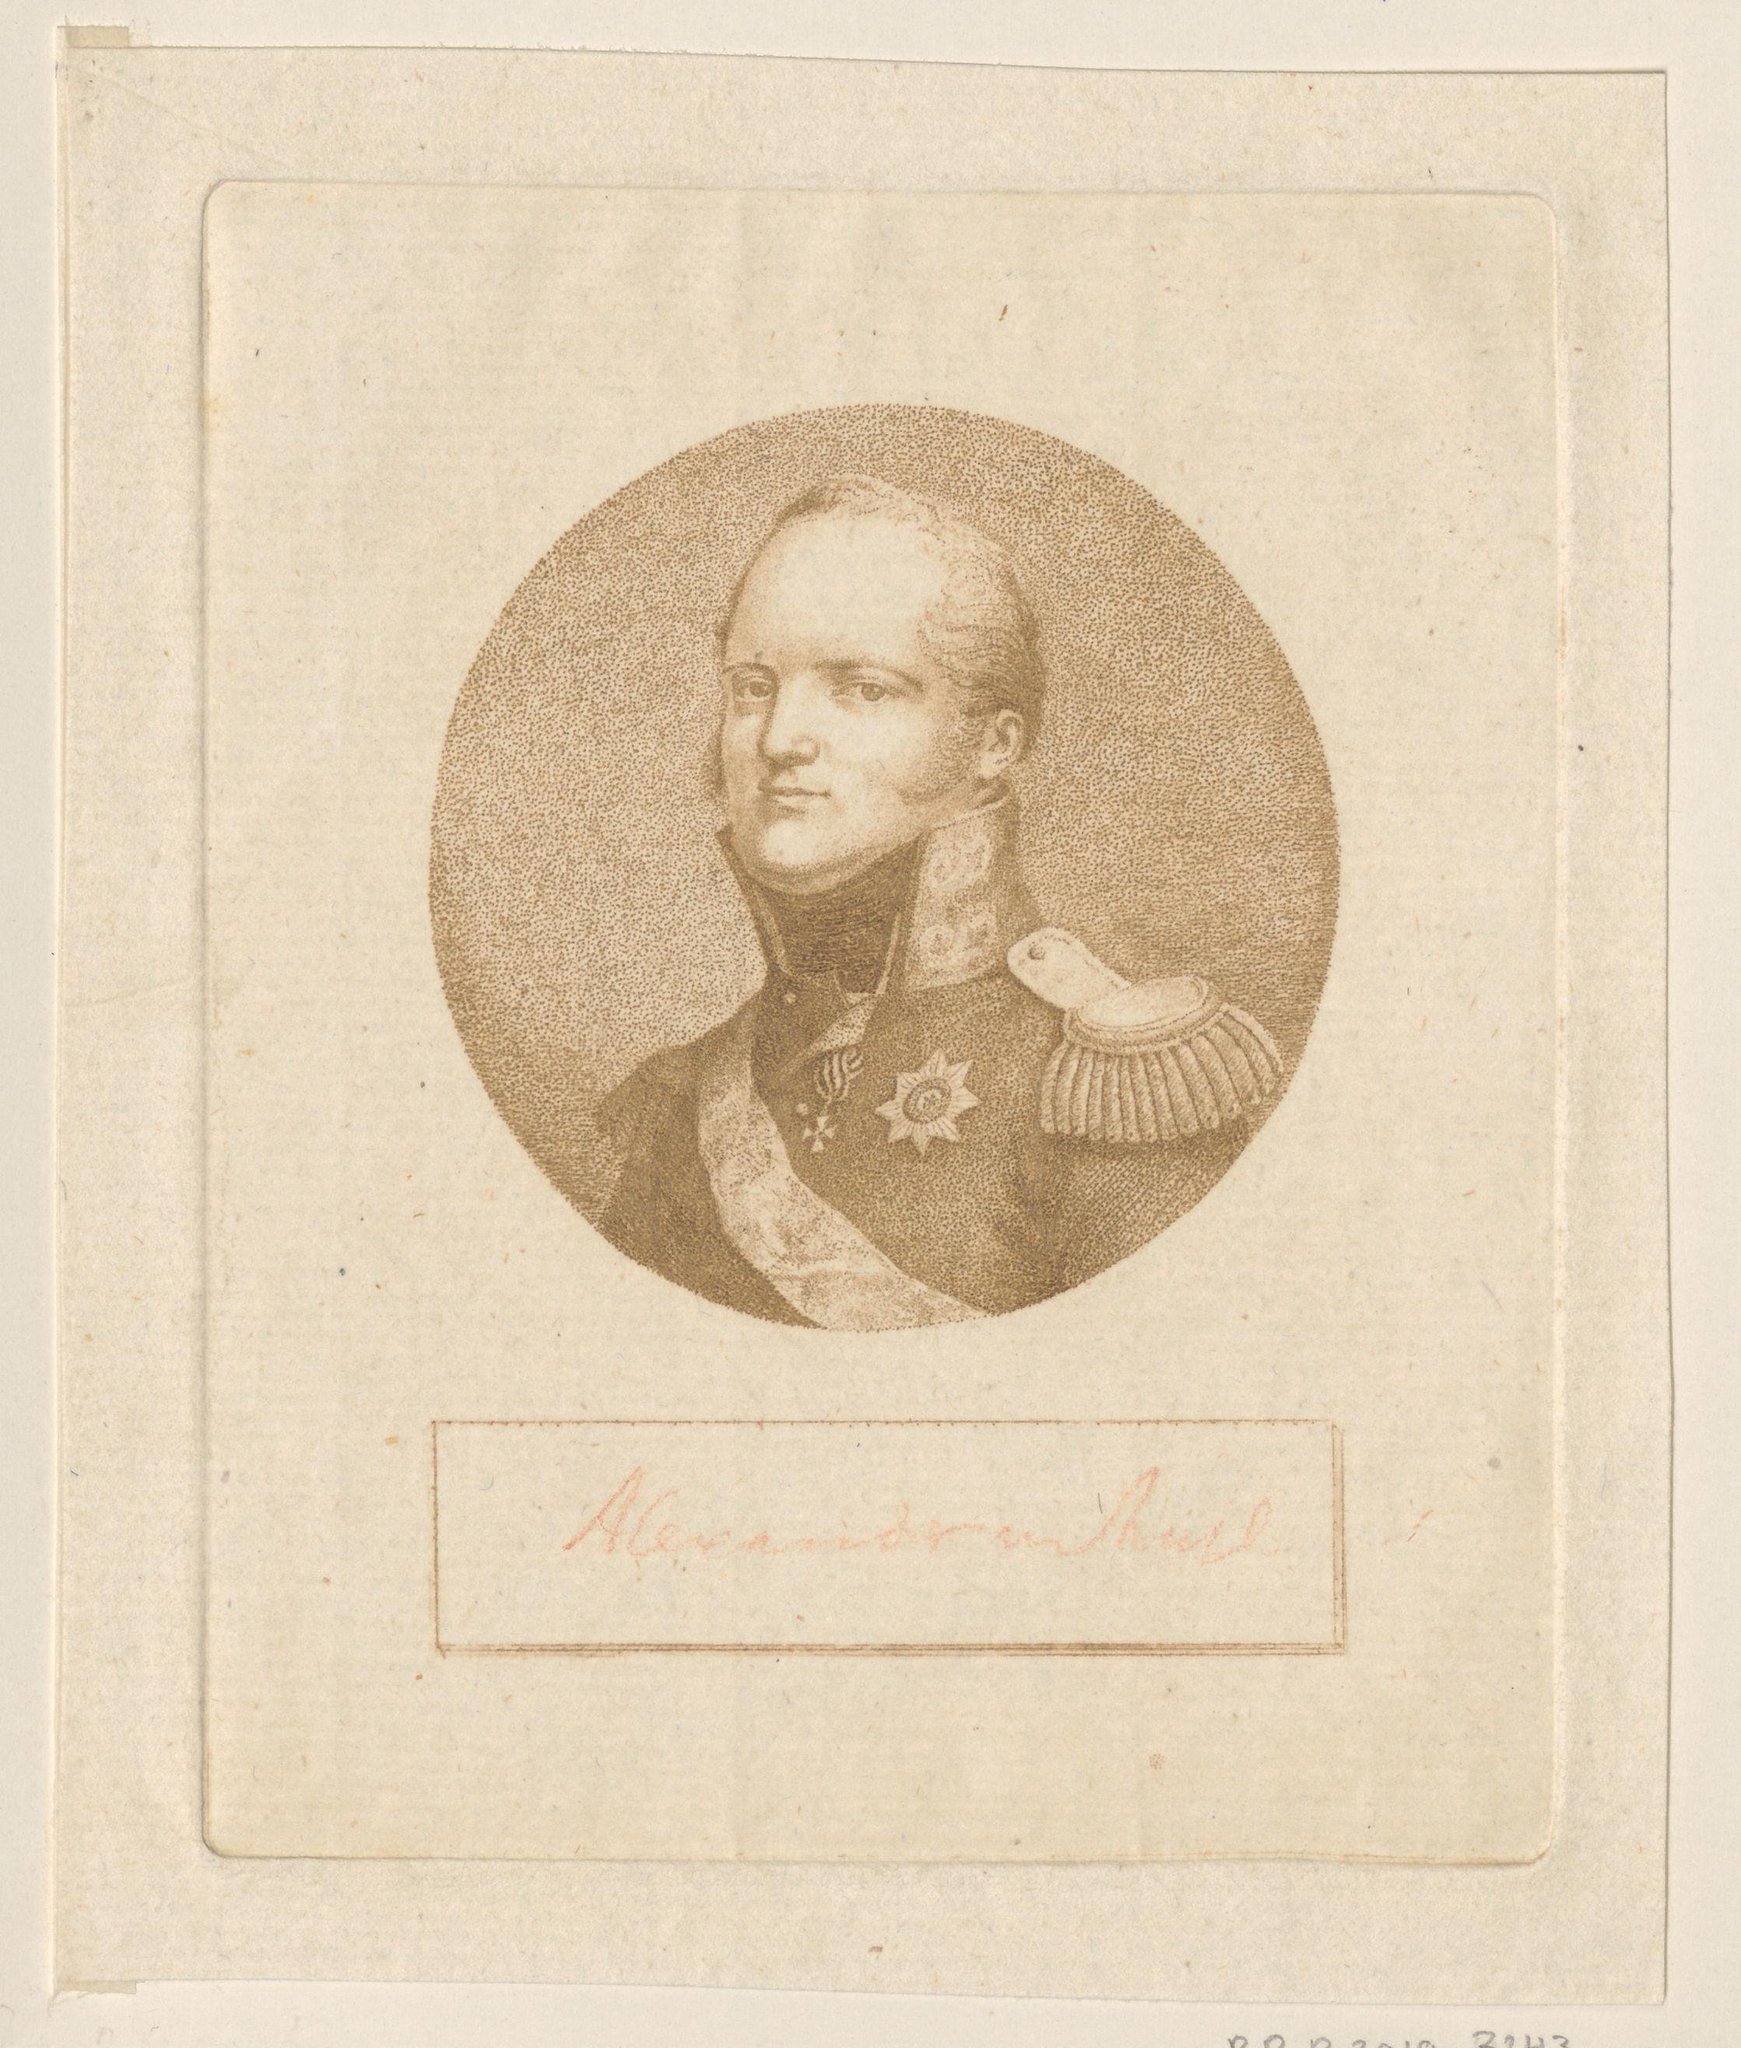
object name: print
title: Portret van Alexander I, tsaar van Rusland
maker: ernst willem jan bagelaar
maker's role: draughtsman, print maker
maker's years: 1775-1837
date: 1801-1837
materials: paper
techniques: etching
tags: alexander i (tsaar van rusland), historical persons, emperor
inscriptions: inscription: ‘Alexander [...] Rusl’, collector's mark (false): Lugt 2233